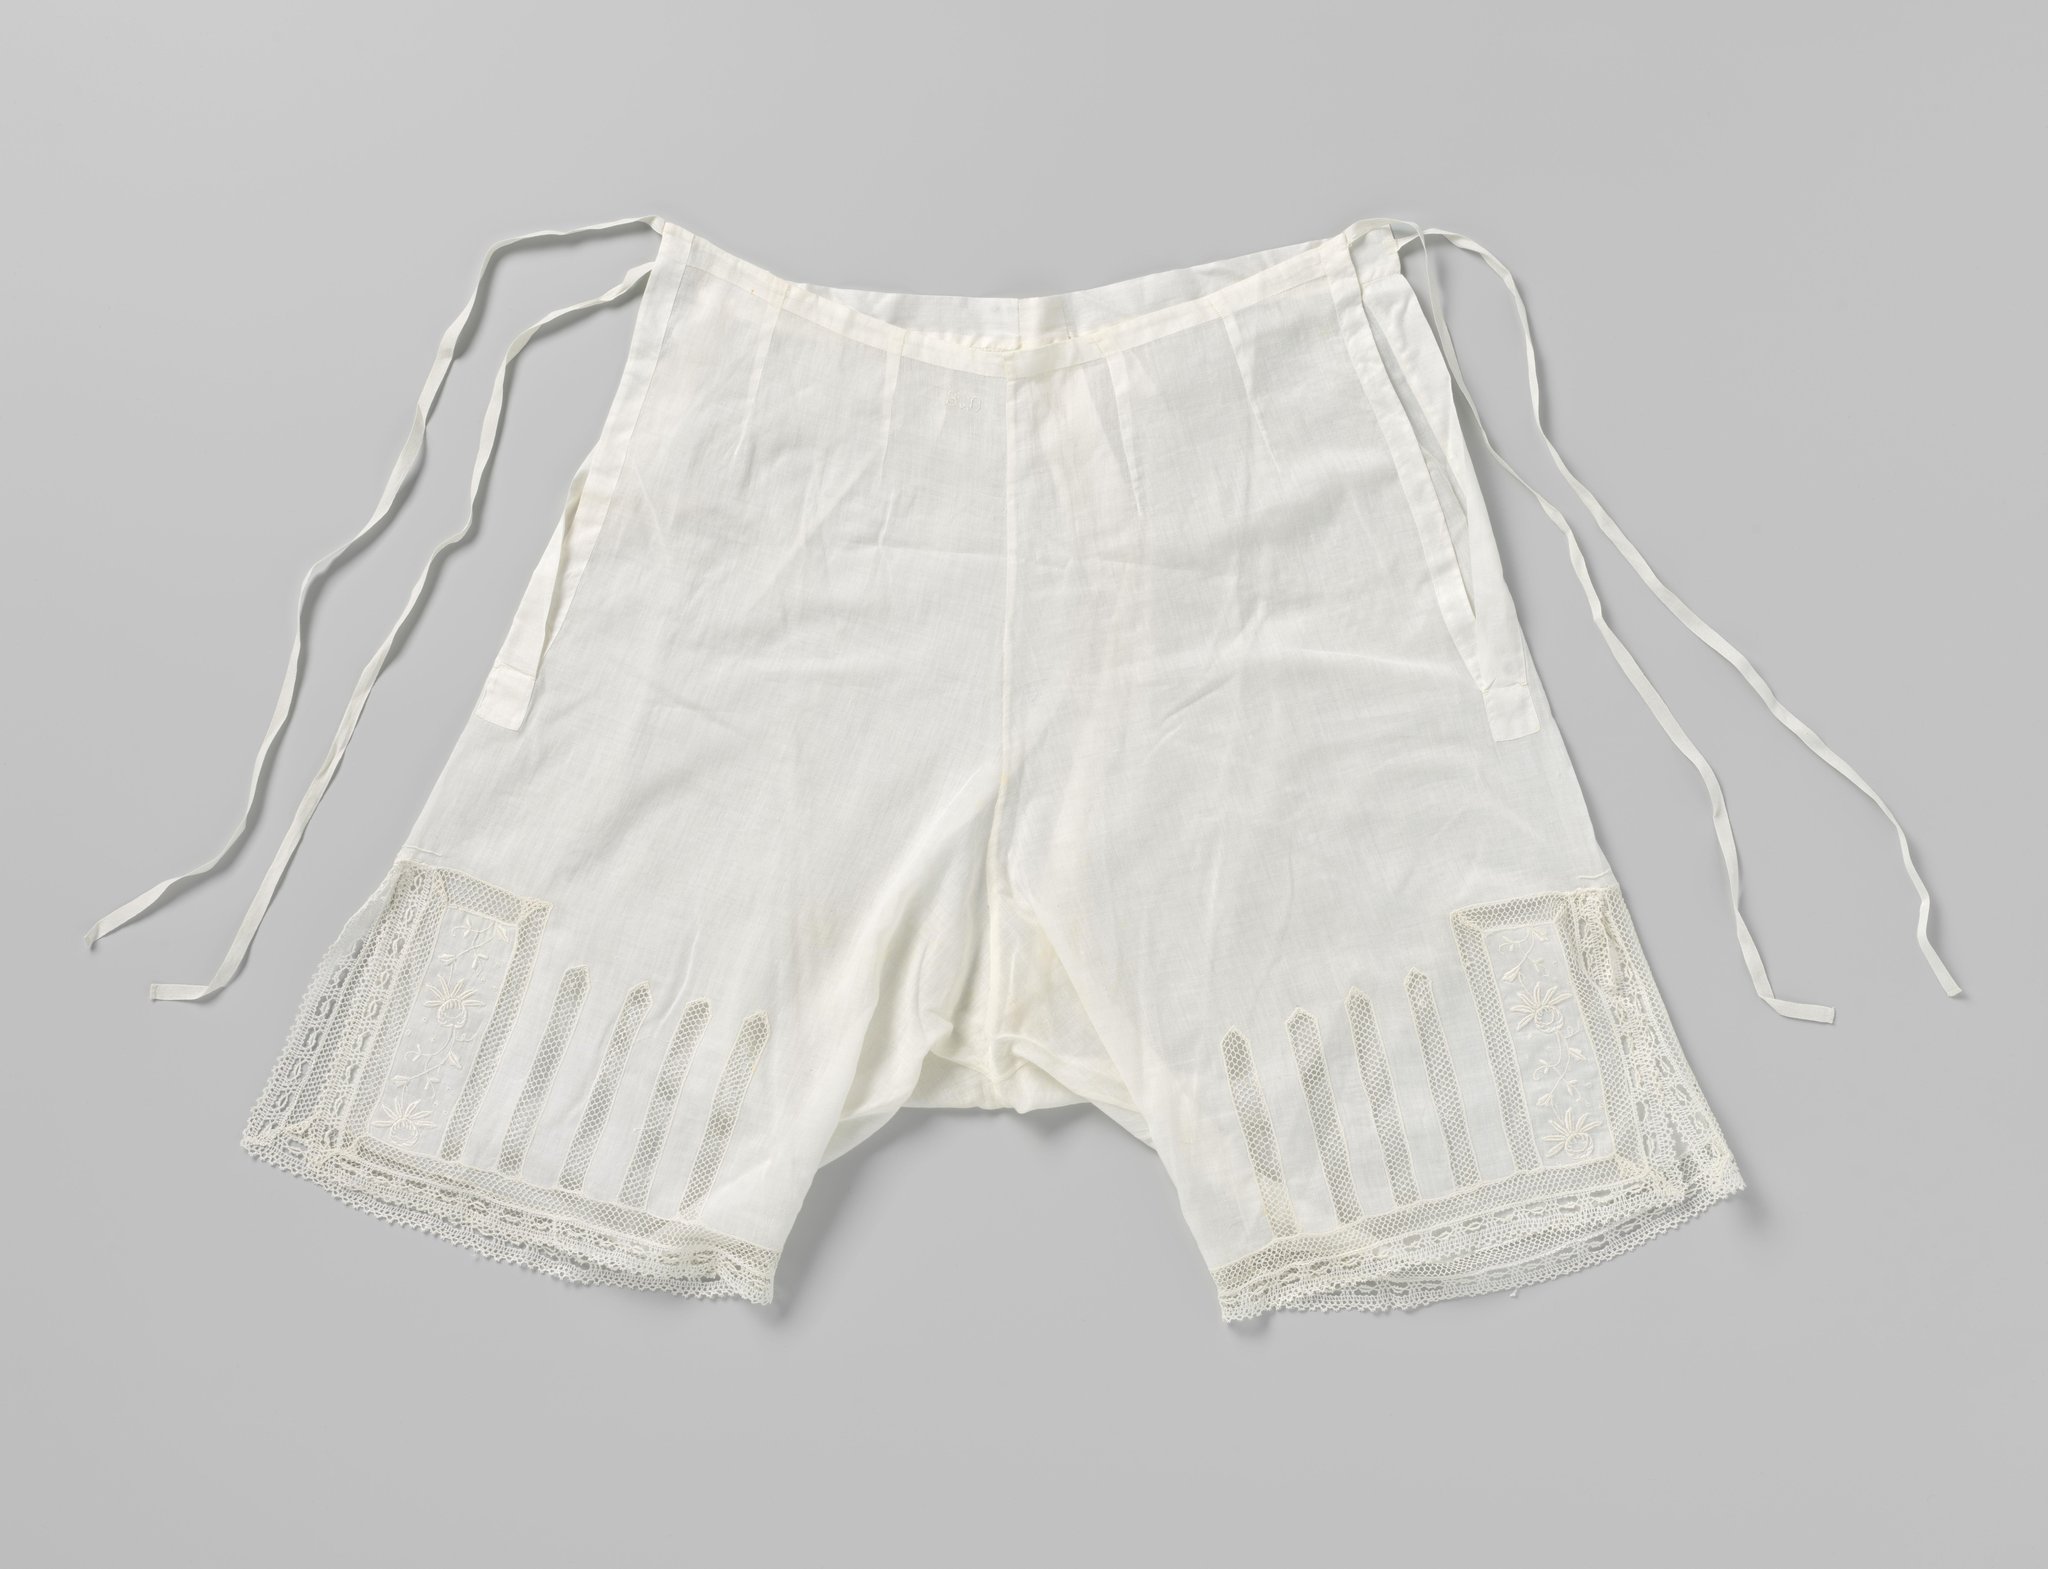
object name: underwear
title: Broek van katoen,onderdeel van driedelige lingerieset, met wit borduurwerk, kant en monogram SvD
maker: Anonymous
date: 1900-1925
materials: cotton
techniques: embroidered, lace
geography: netherlands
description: Broek van katoen. Model: gladde, wijde pijpen en versierd met machinaal witwerk langs de splitten. Gladde voorkant; gerimpeld achterpand. Bandsluiting.et monogram SvD (S. van Dorp). Broek is onderdeel van een driedelige lingerieset.